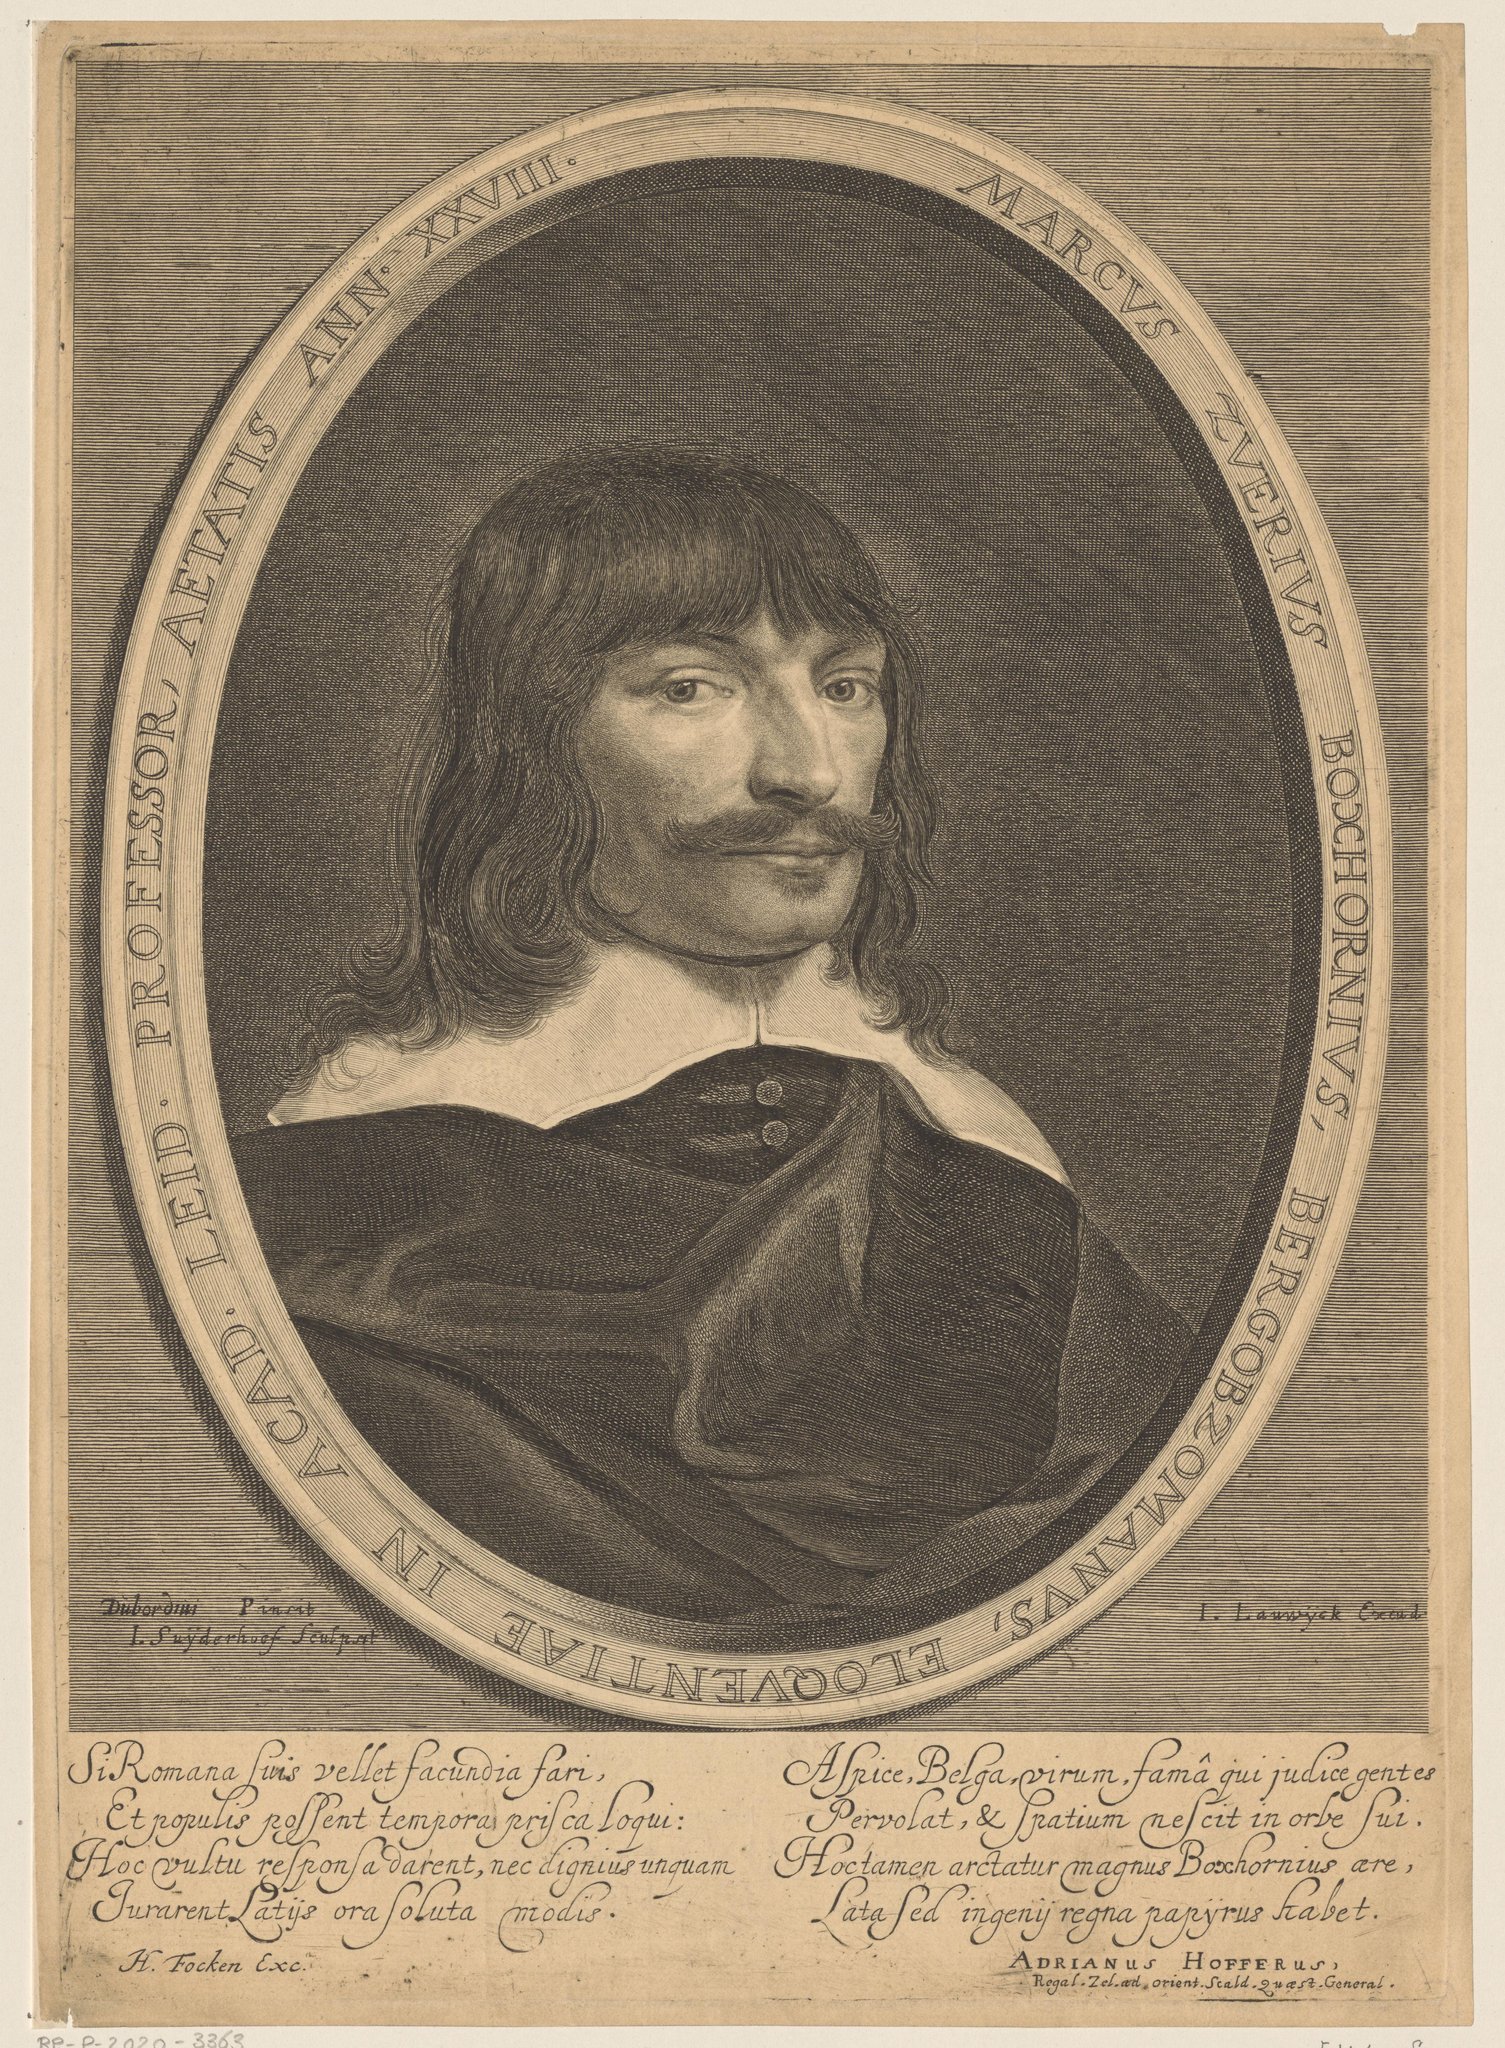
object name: print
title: Portret van Marcus Zuerius Boxhorn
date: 1665-1686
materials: paper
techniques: engraving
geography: leiden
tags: bergen op zoom, leiden, marcus zuerius boxhorn, scholar, philosopher, historical persons